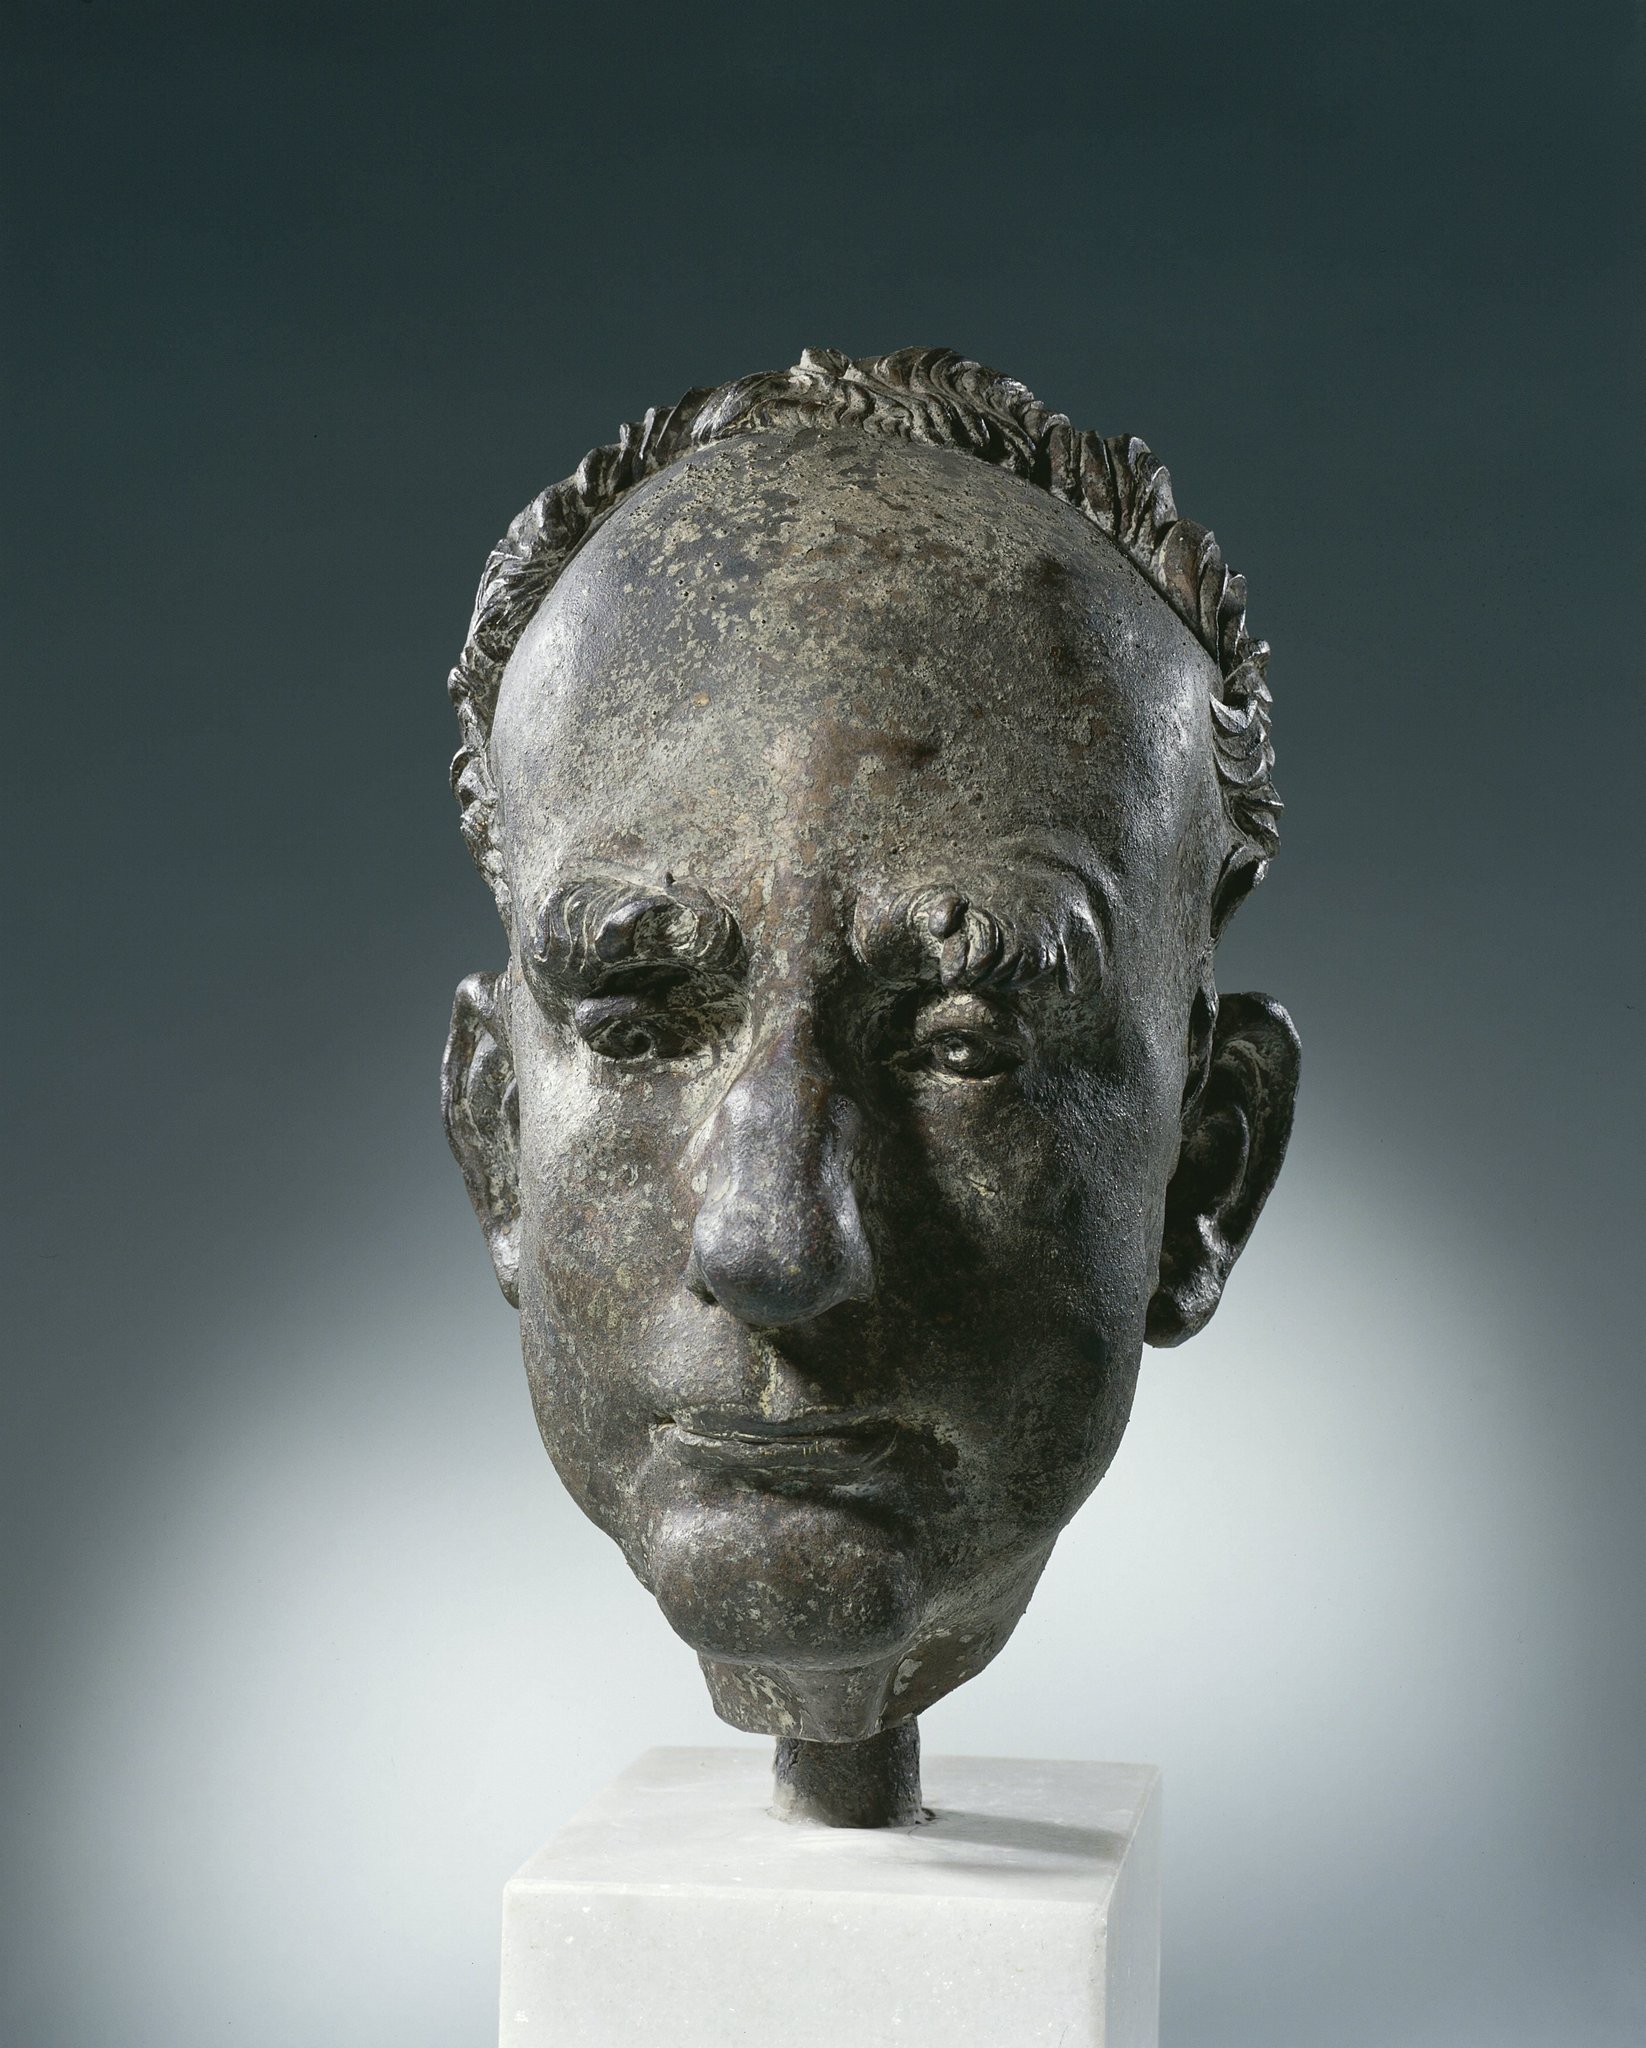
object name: sculpture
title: Arthur van Schendel (1910-1979)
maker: arthur spronken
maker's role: sculptor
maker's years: 1930-2018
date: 1975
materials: bronze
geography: kelmond